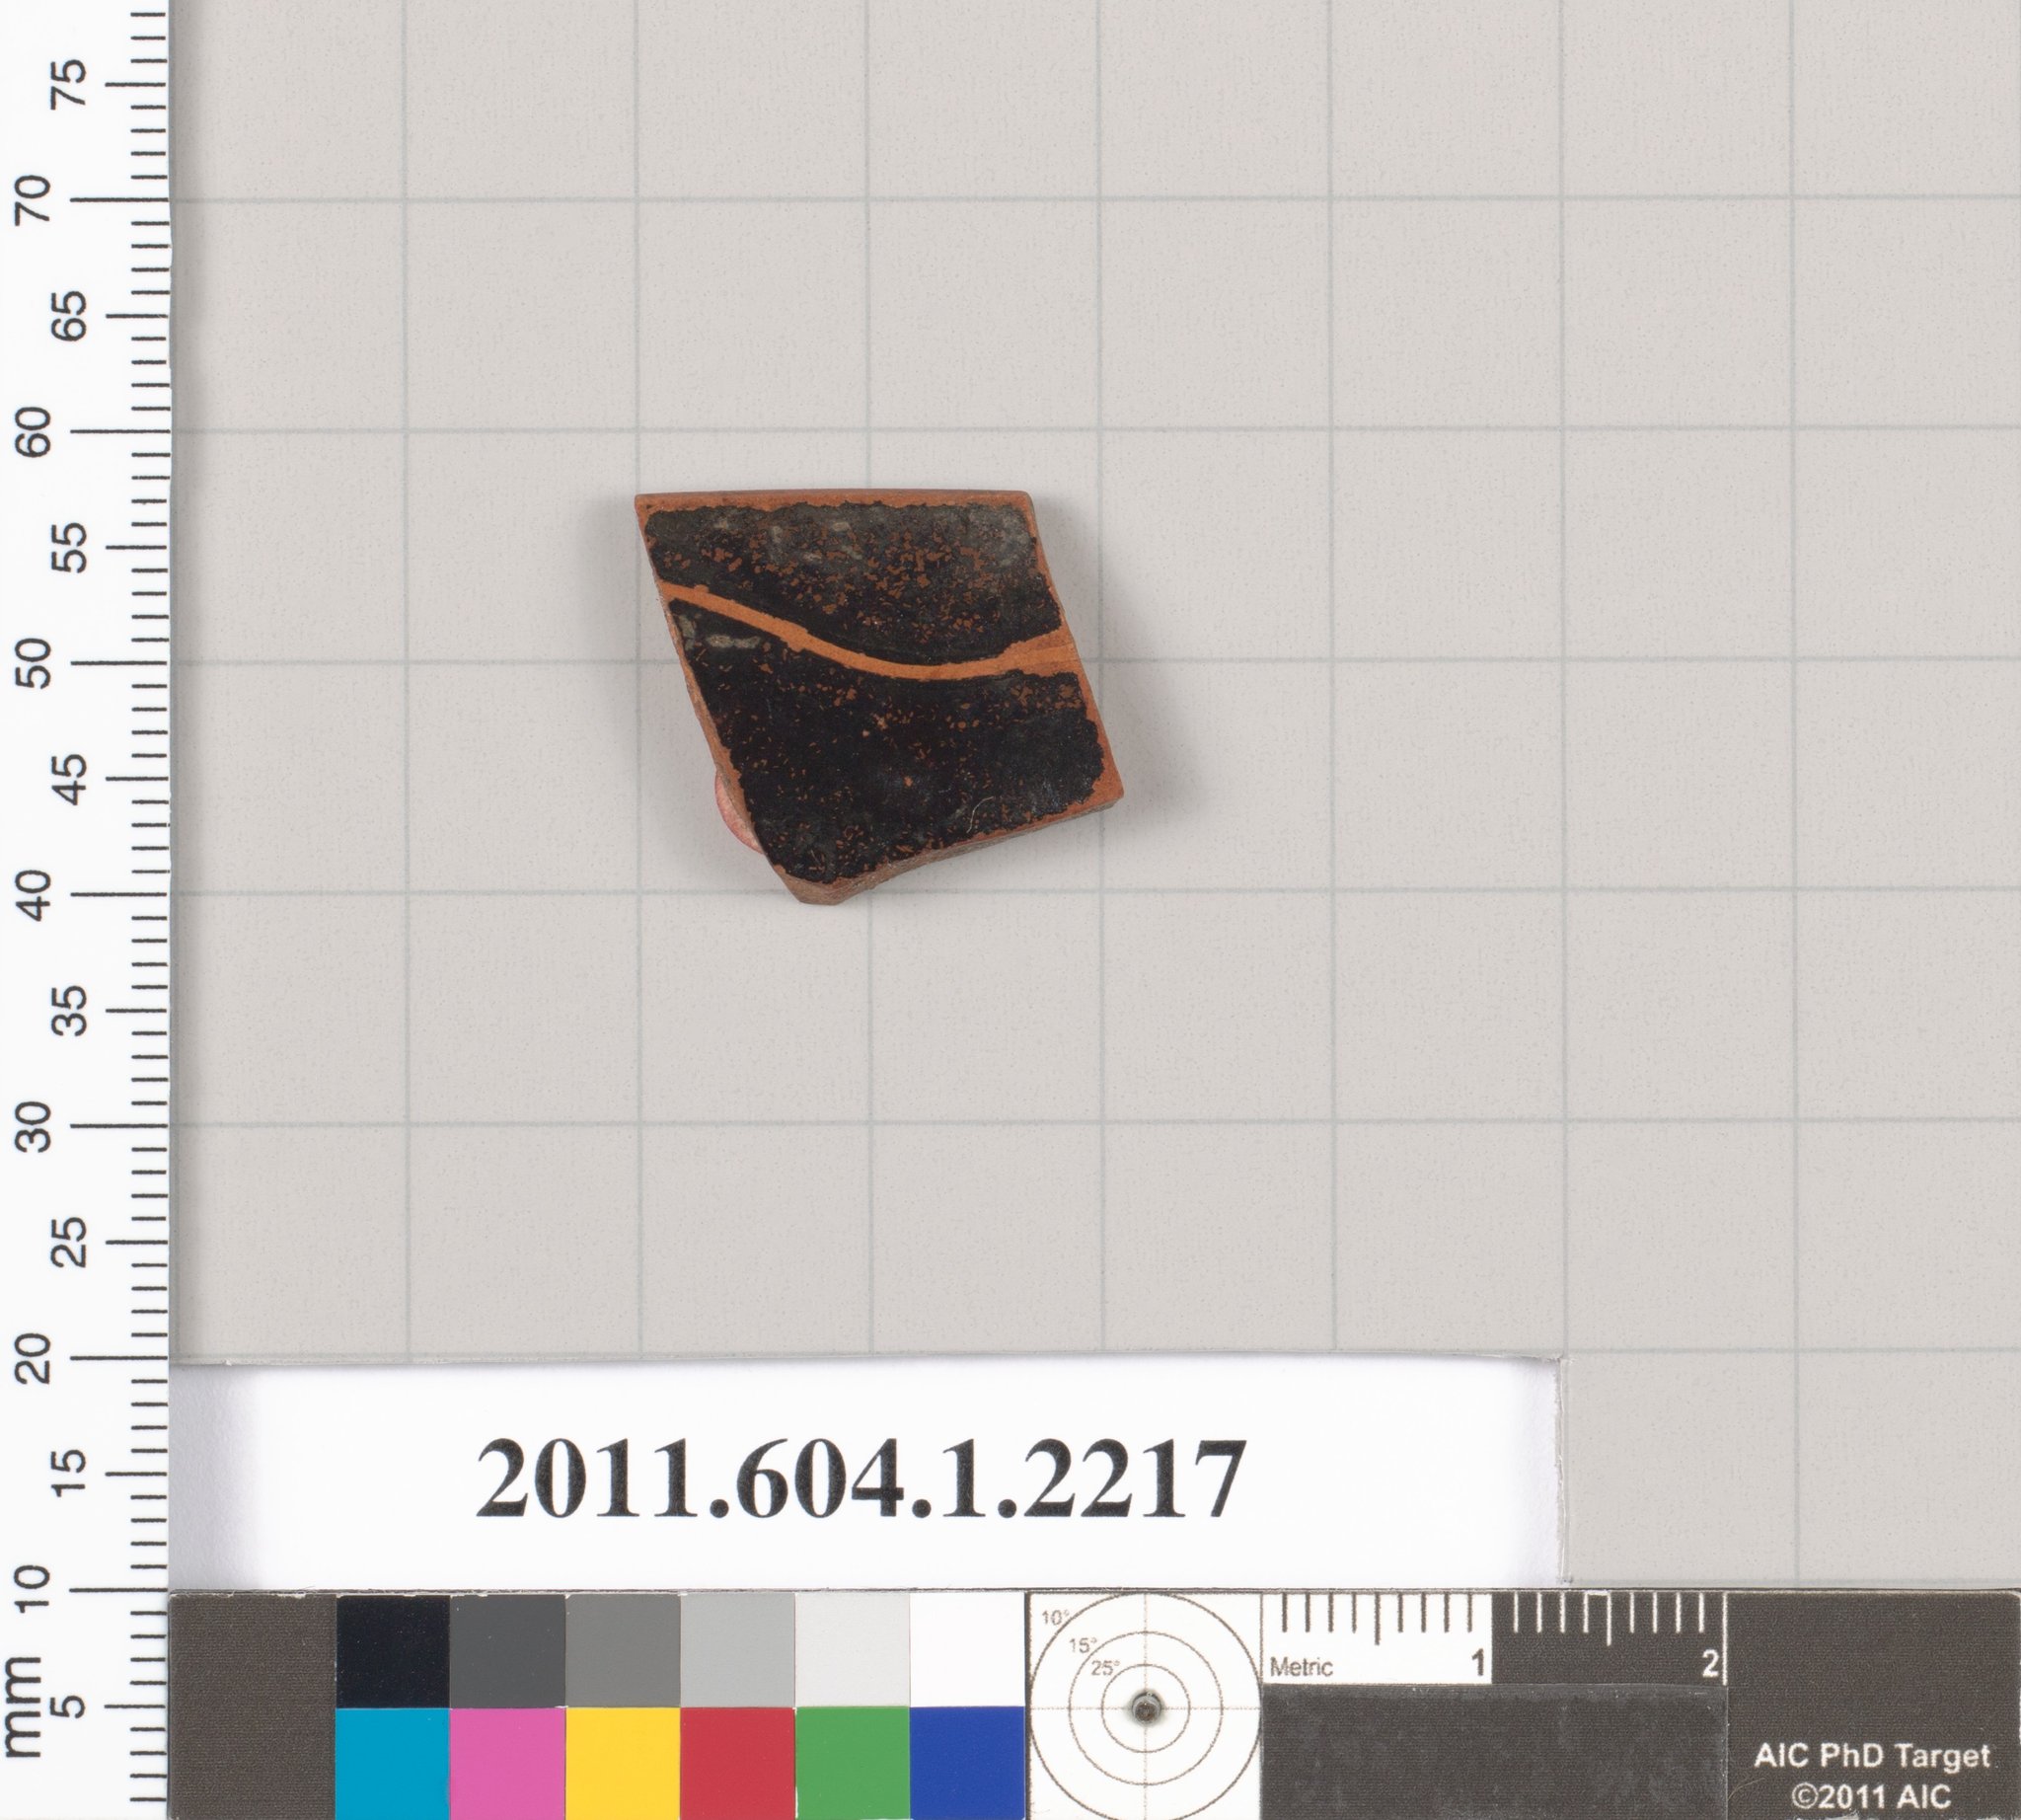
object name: kylix fragment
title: Terracotta rim fragment of a kylix (drinking cup)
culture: greek, attic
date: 475-451 BCE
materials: terracotta